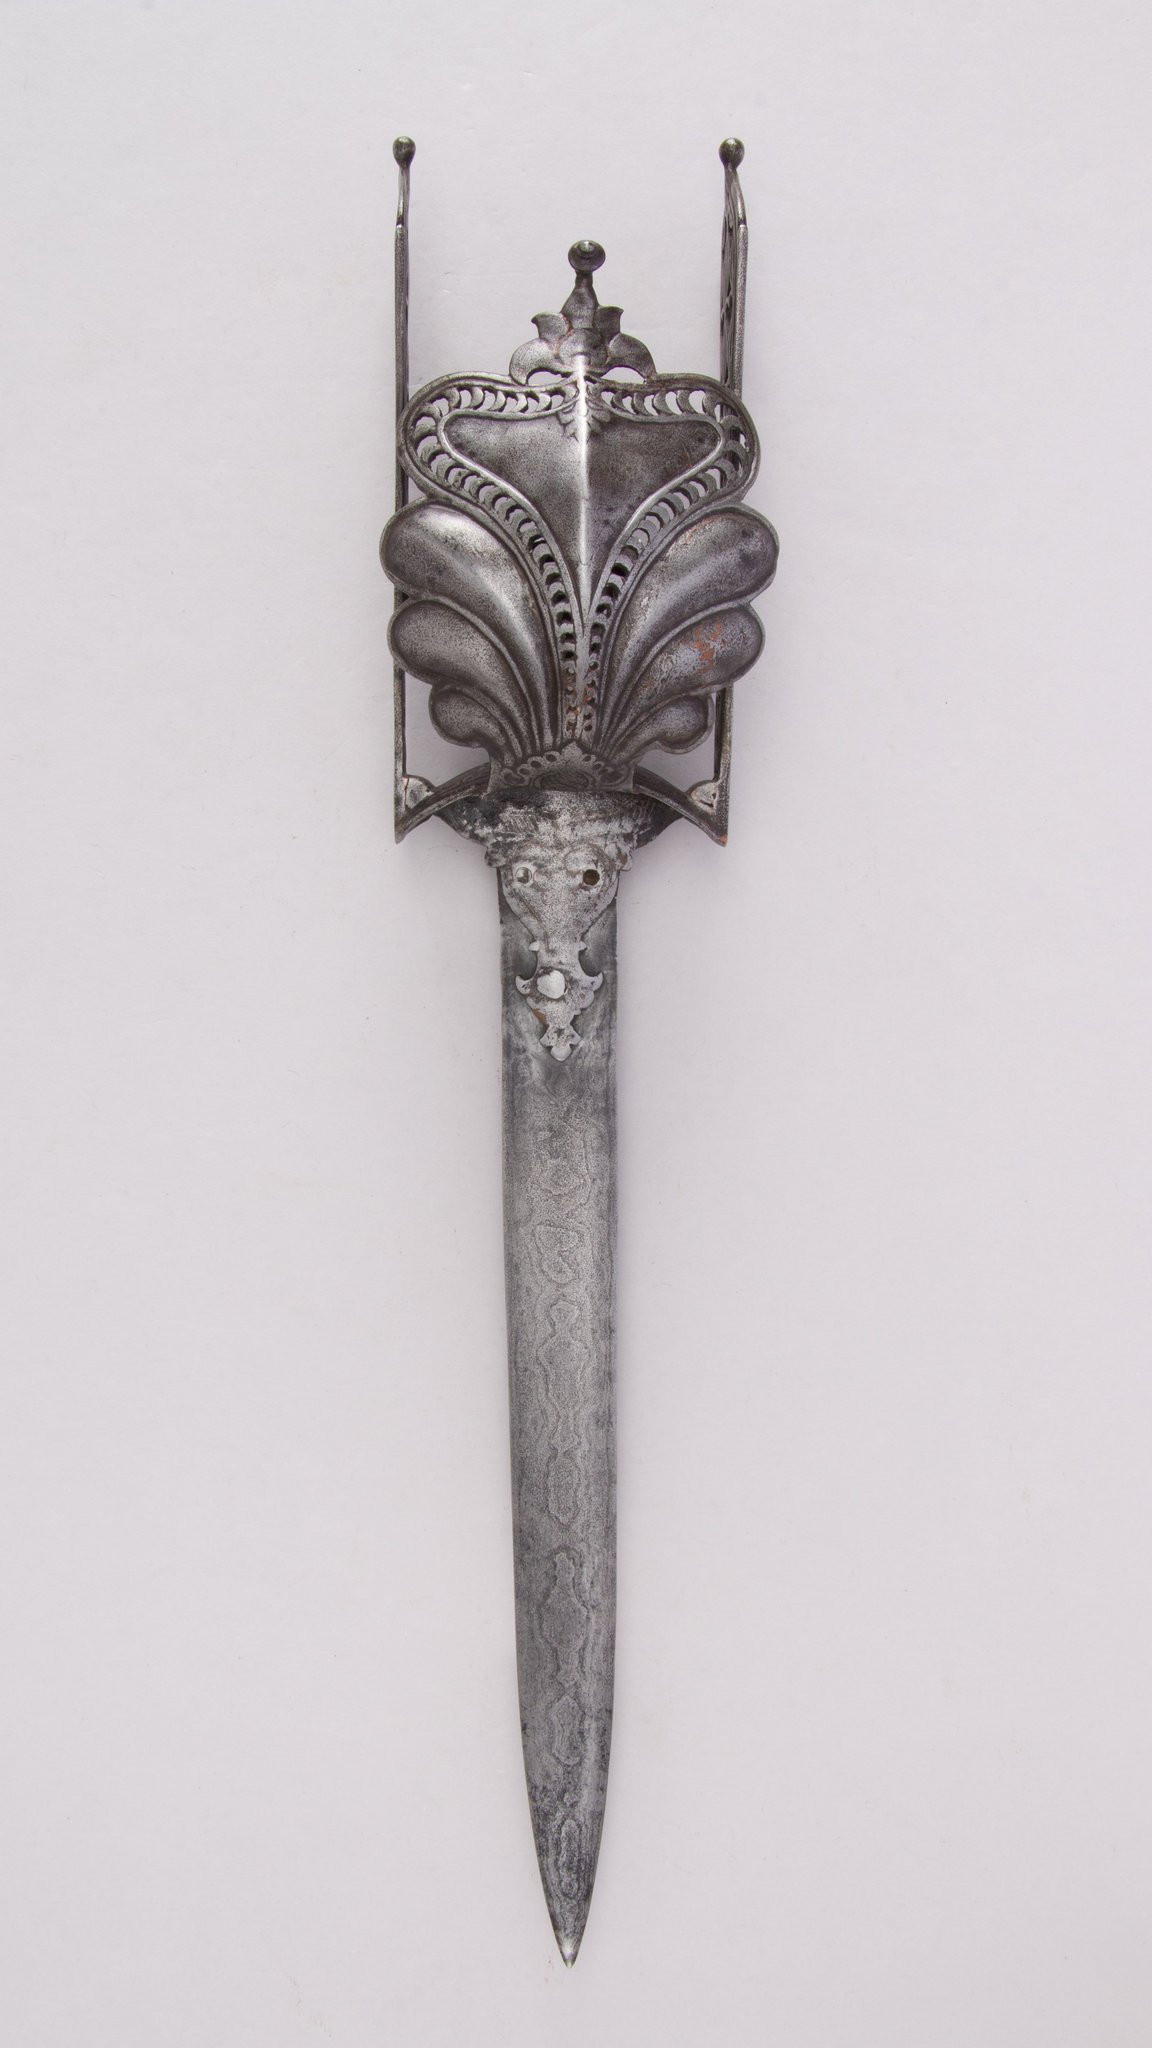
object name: dagger katar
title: Guarded Dagger (Katar)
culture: indian, thanjavur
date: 1601-1700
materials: copper, steel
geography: india